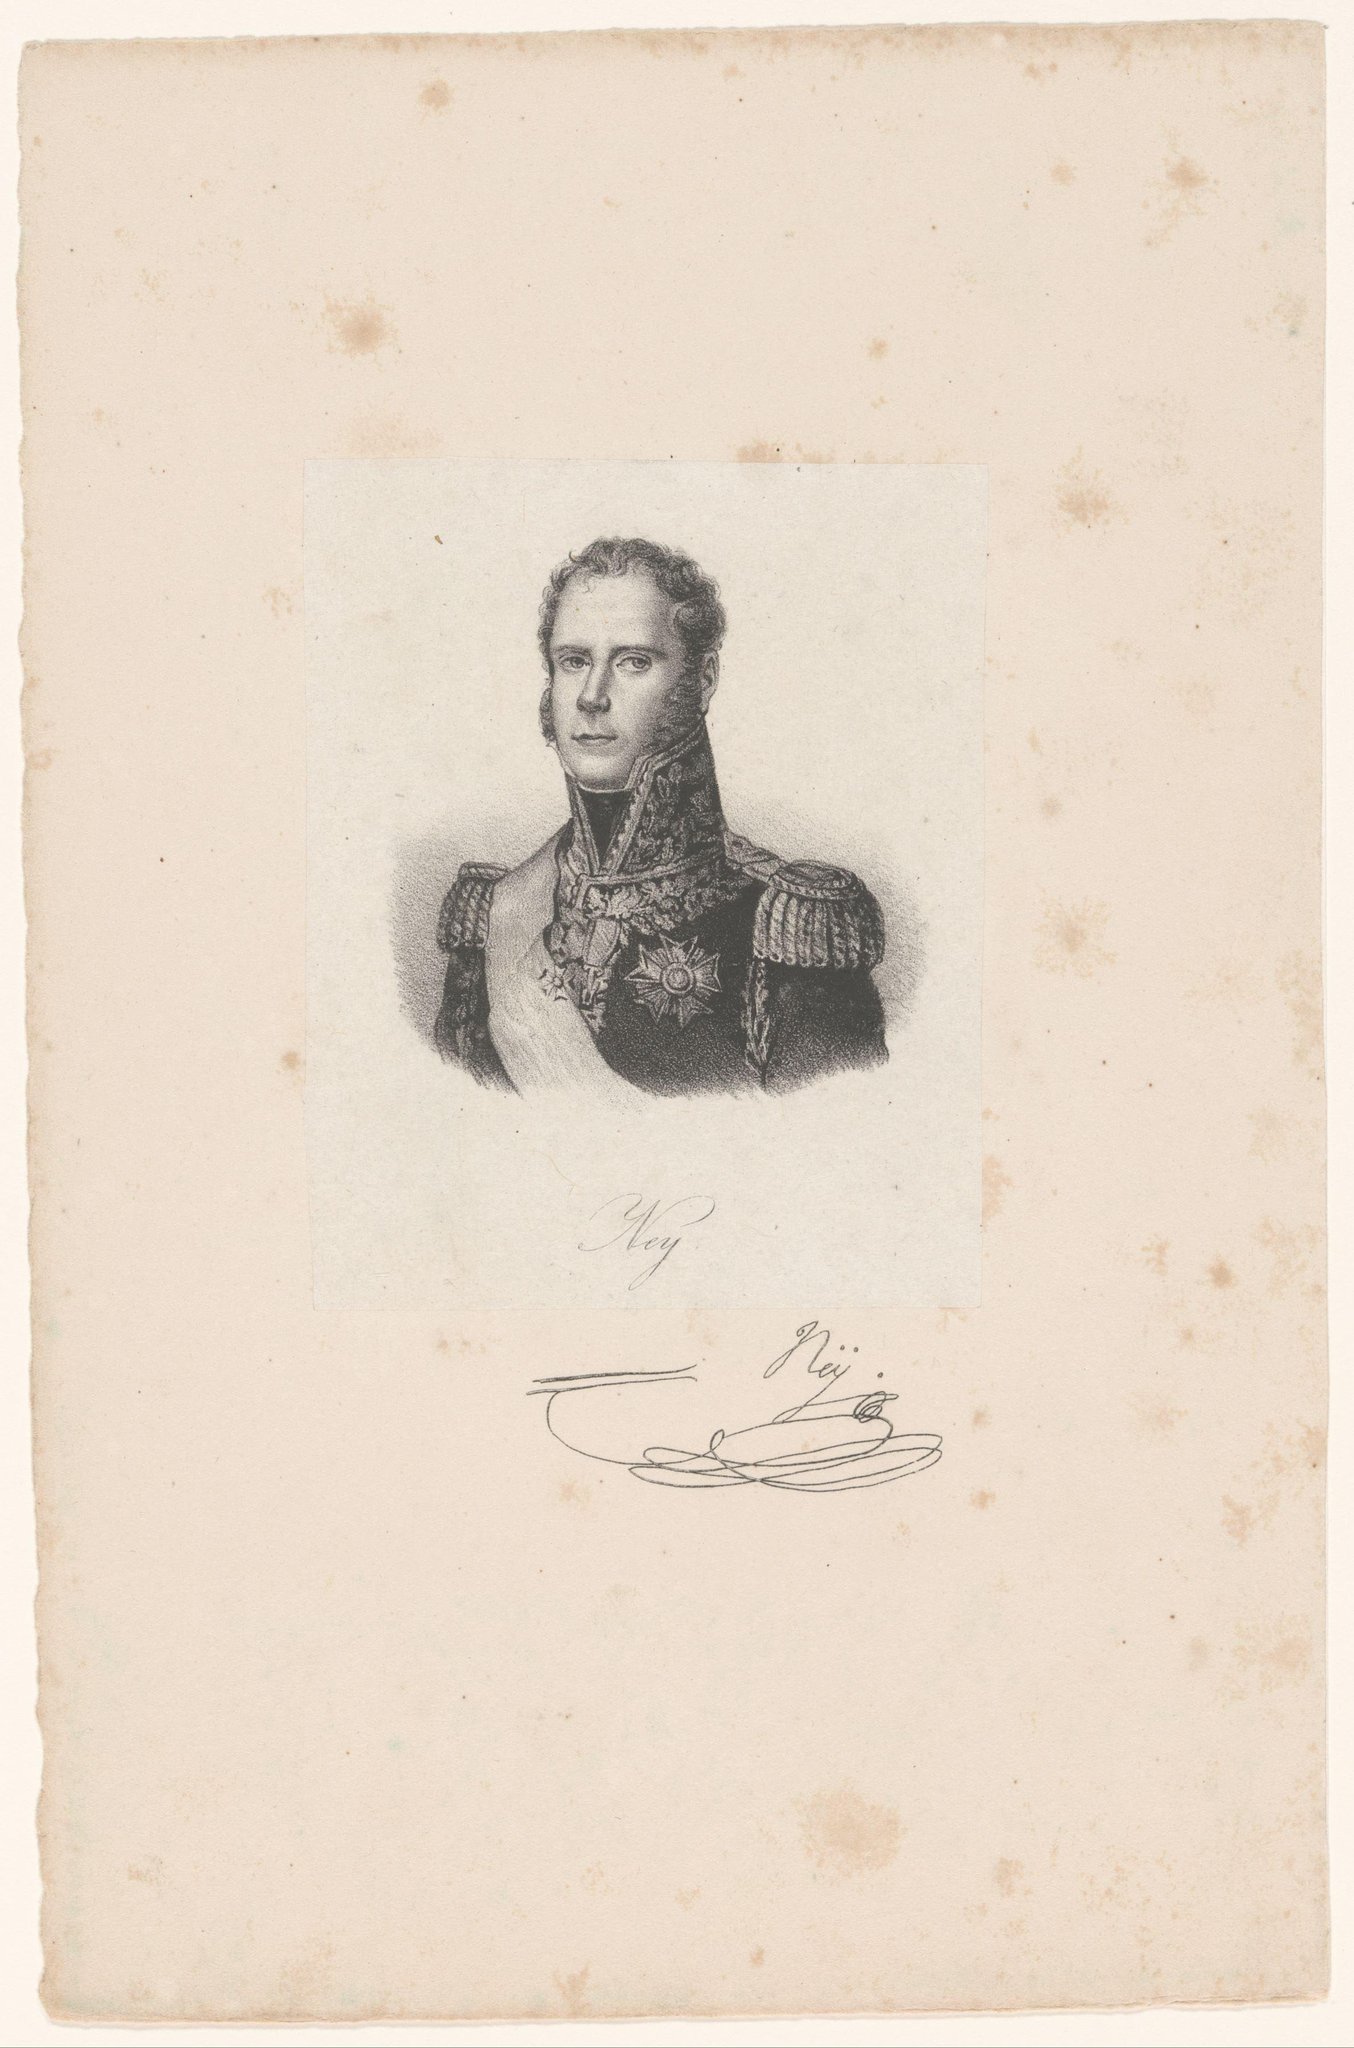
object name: print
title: Ney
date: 1825-1842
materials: paper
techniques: lithograph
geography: paris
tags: paris, historical persons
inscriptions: collector's mark: Lugt 2228a